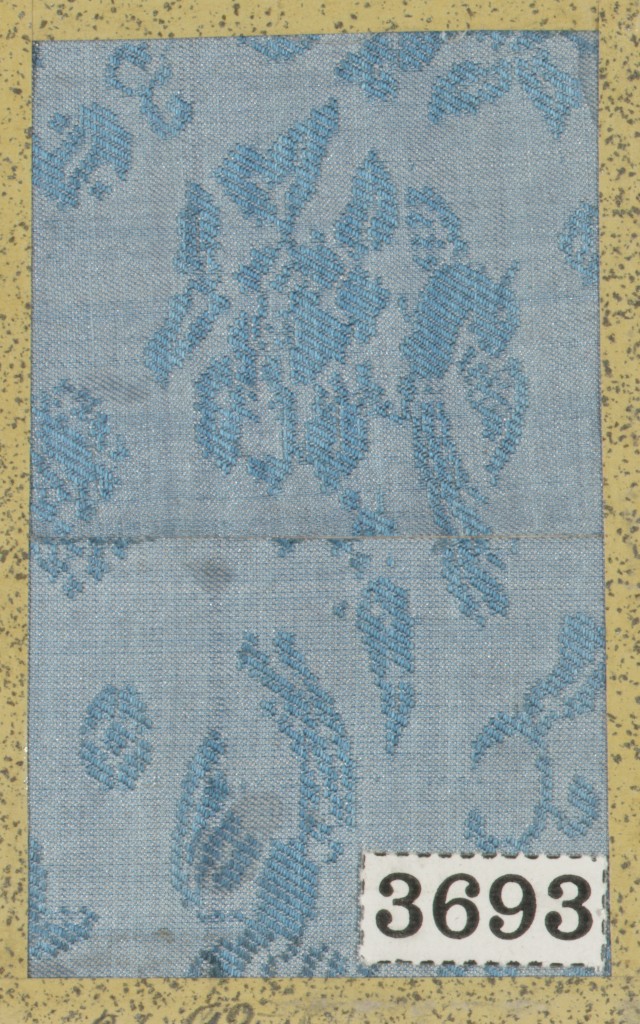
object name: sample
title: Textile Sample from Sample Book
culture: japanese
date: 1801-1900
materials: silk